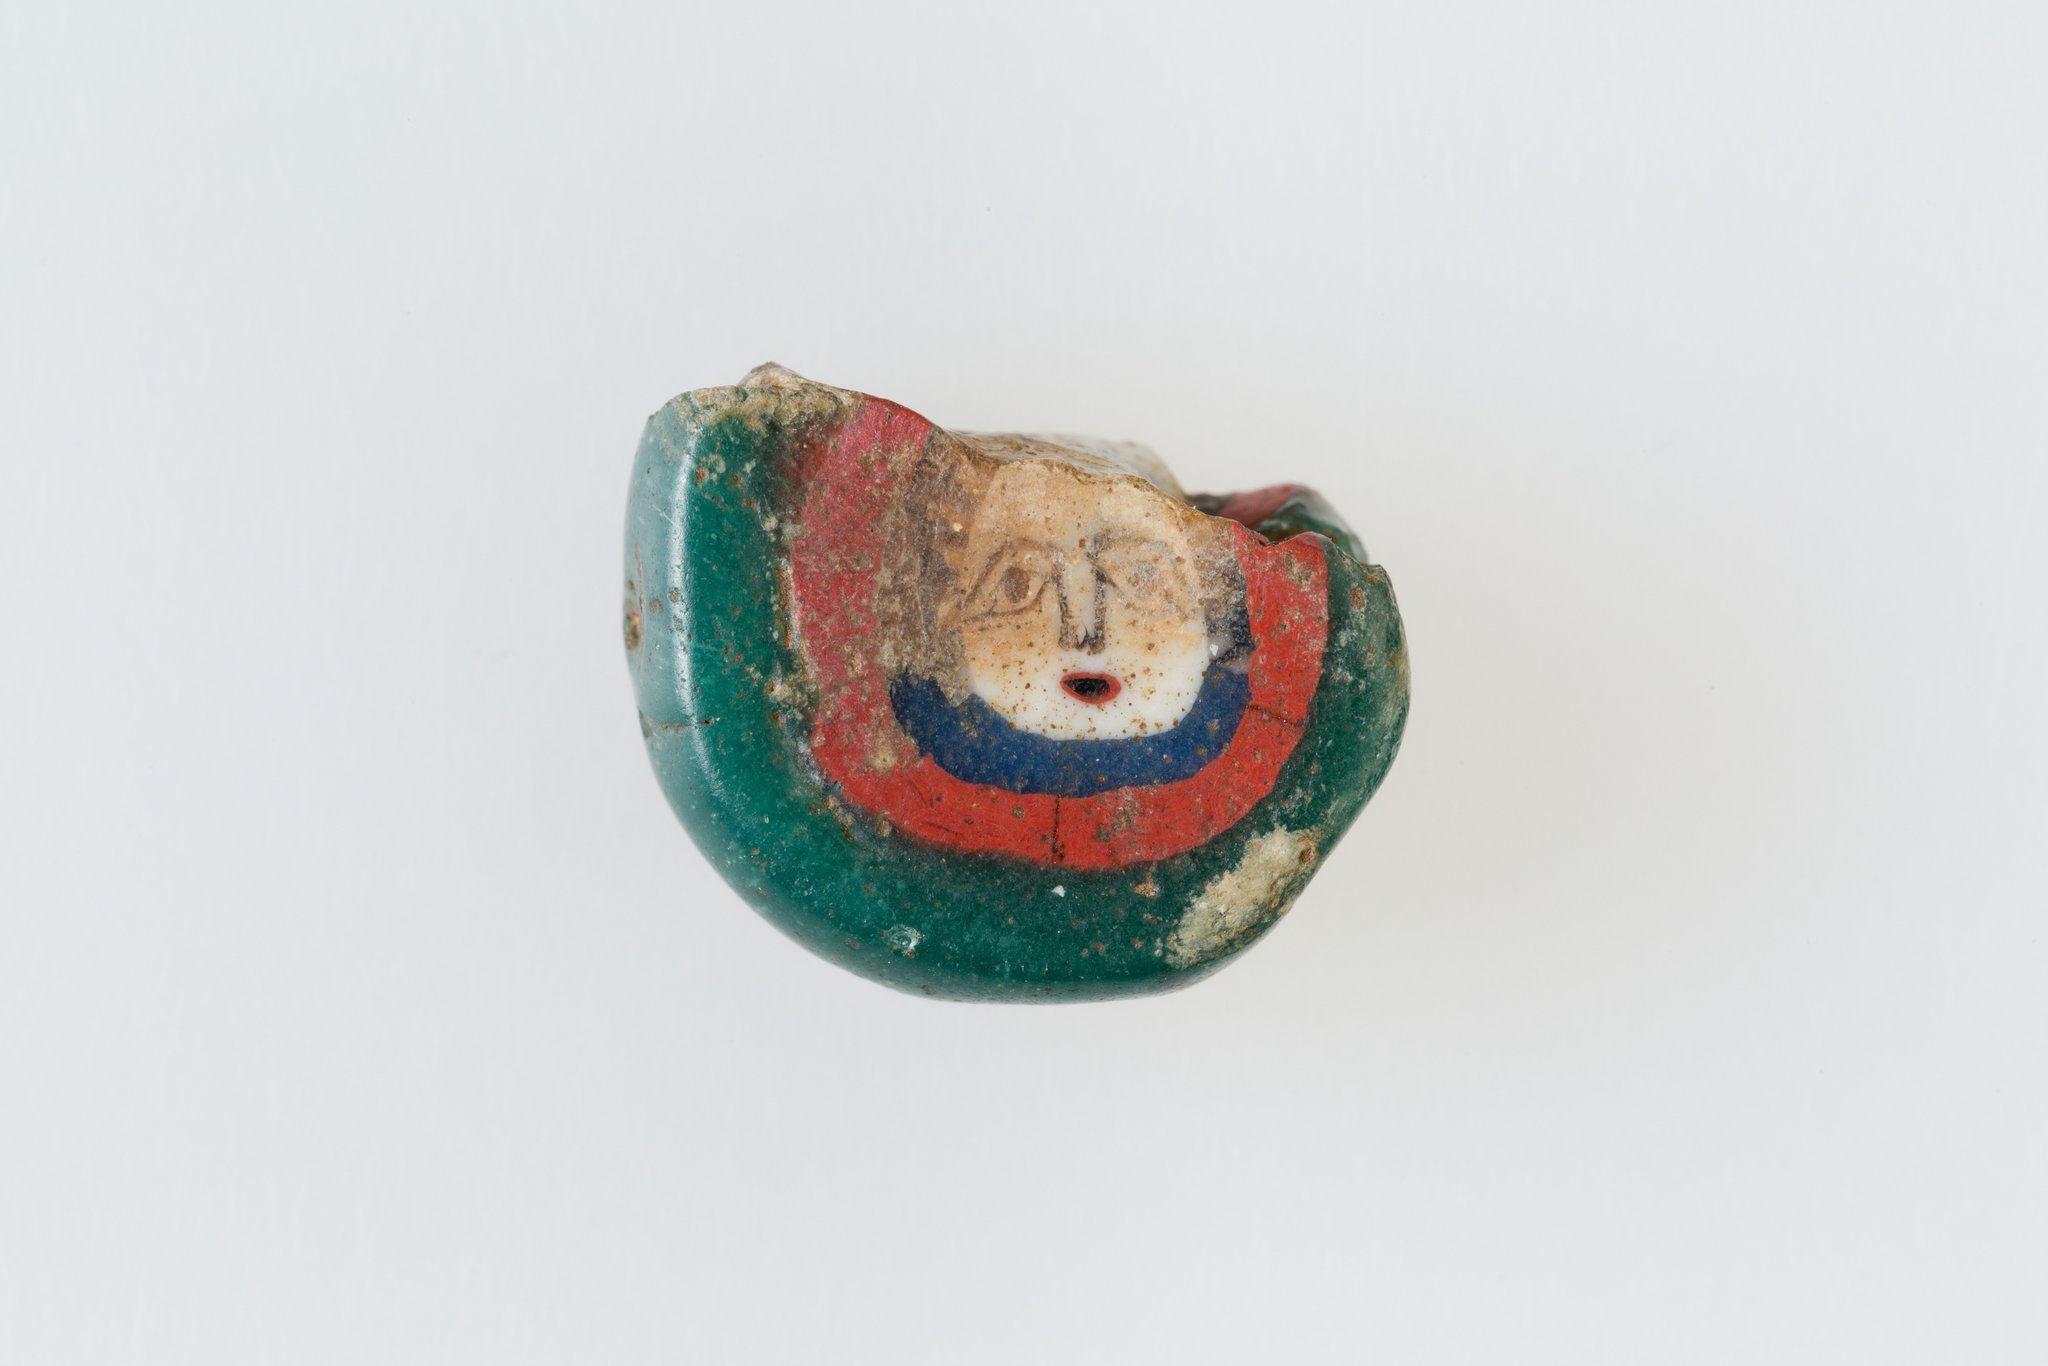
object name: inlay, face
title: Inlay/bead blank with face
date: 100 BCE-100 CE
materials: glass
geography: egypt